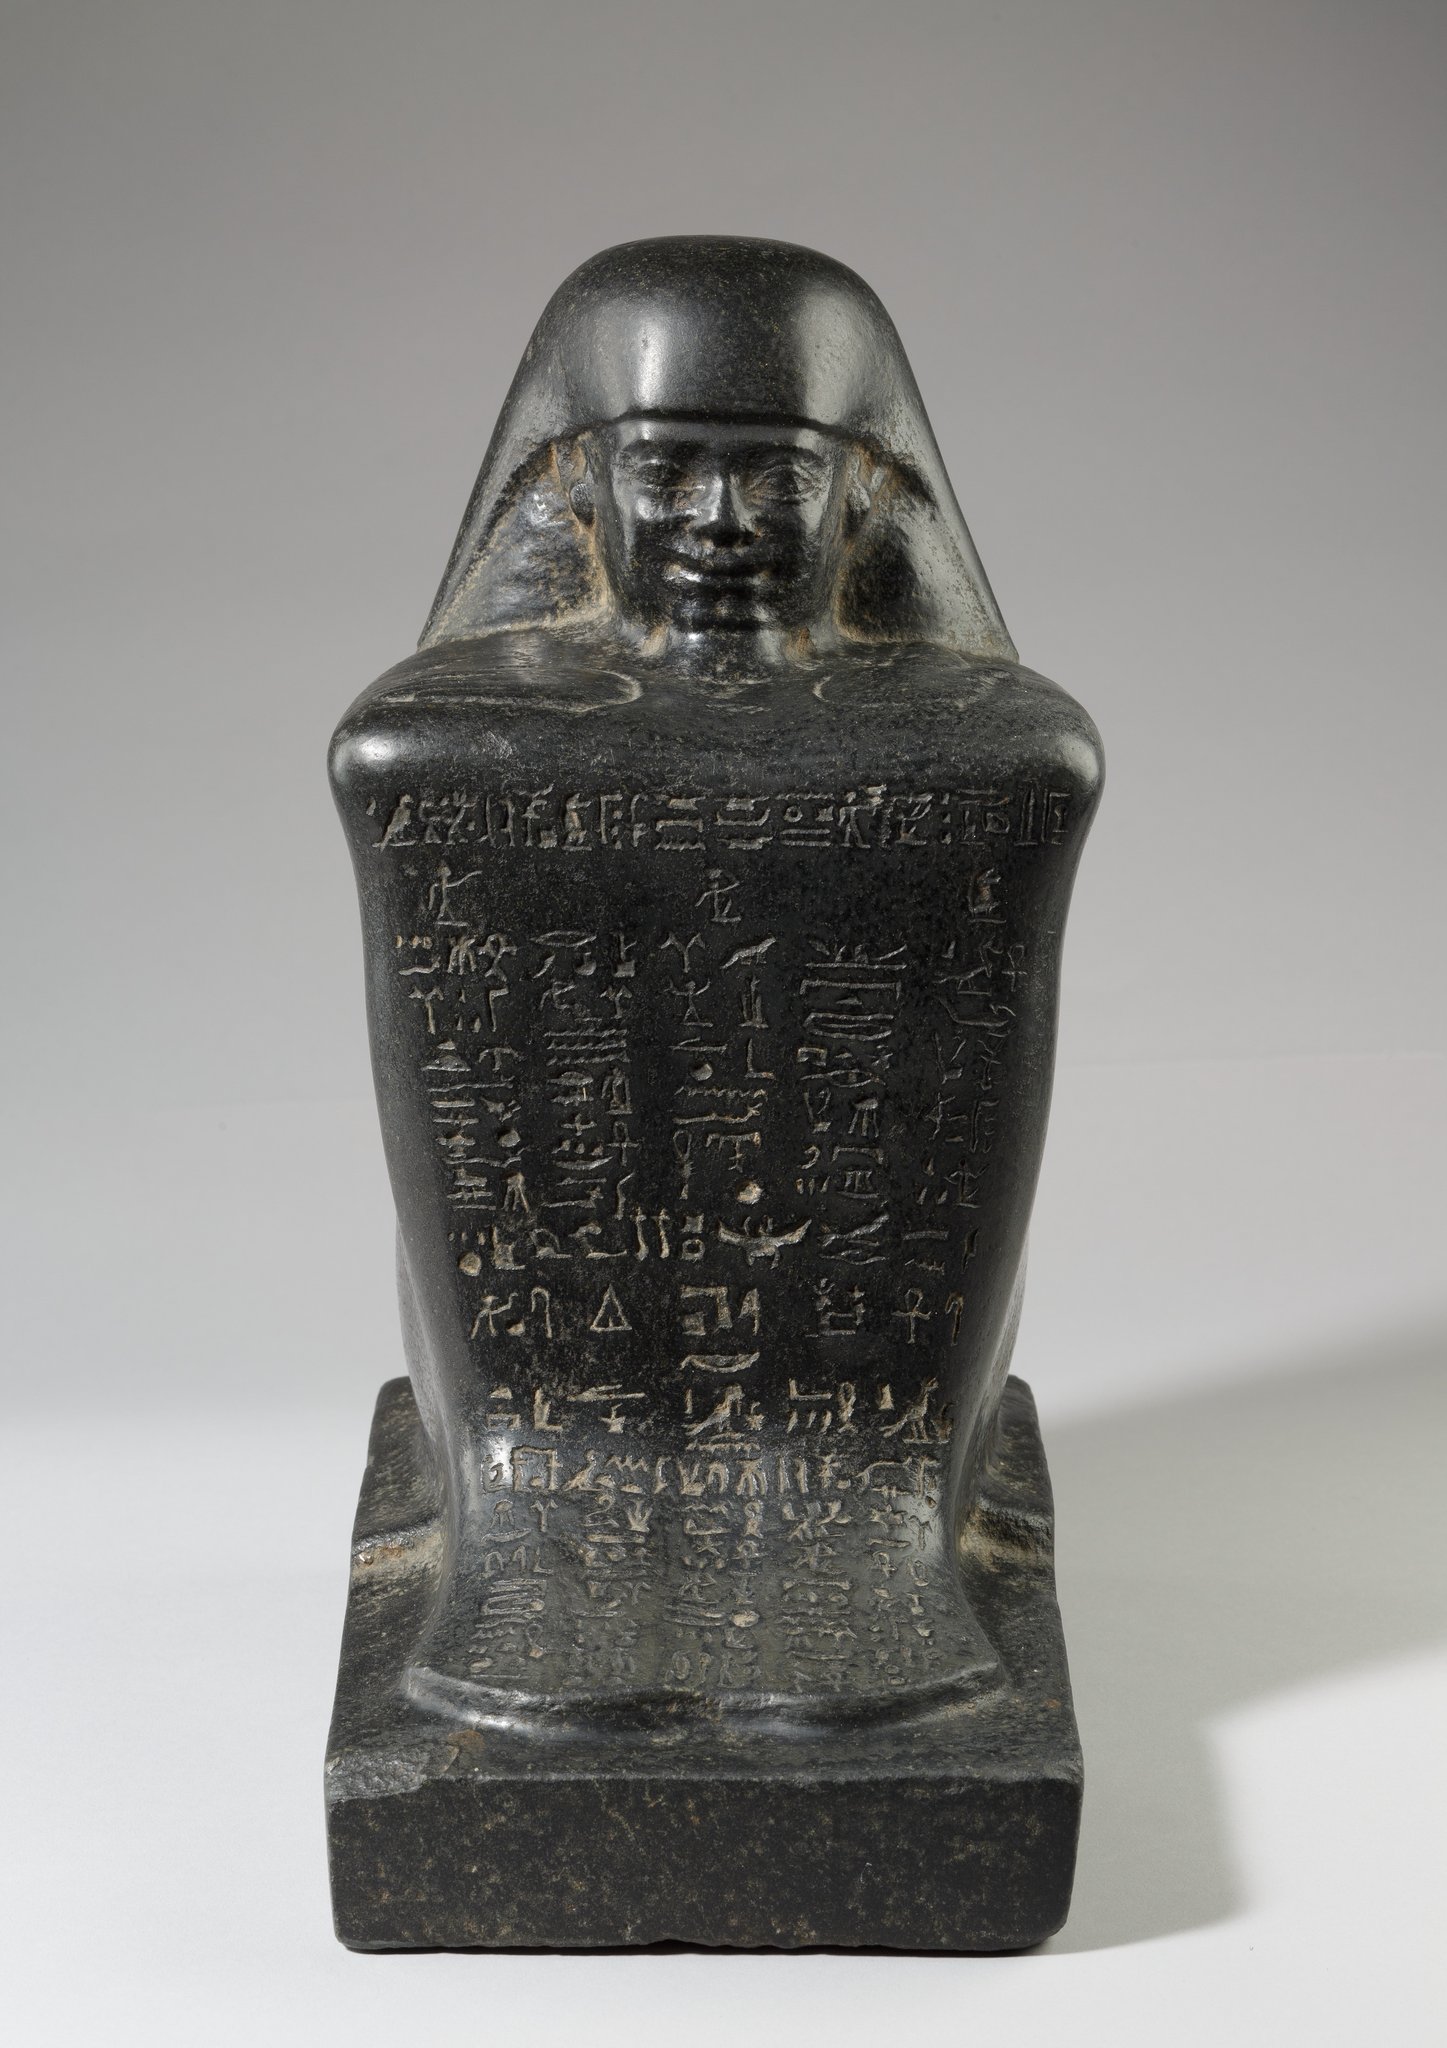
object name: block statue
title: Block Statue of Nespamedu, son of Paiunhor and Tanethut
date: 300-201 BCE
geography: egypt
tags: men,hieroglyphs